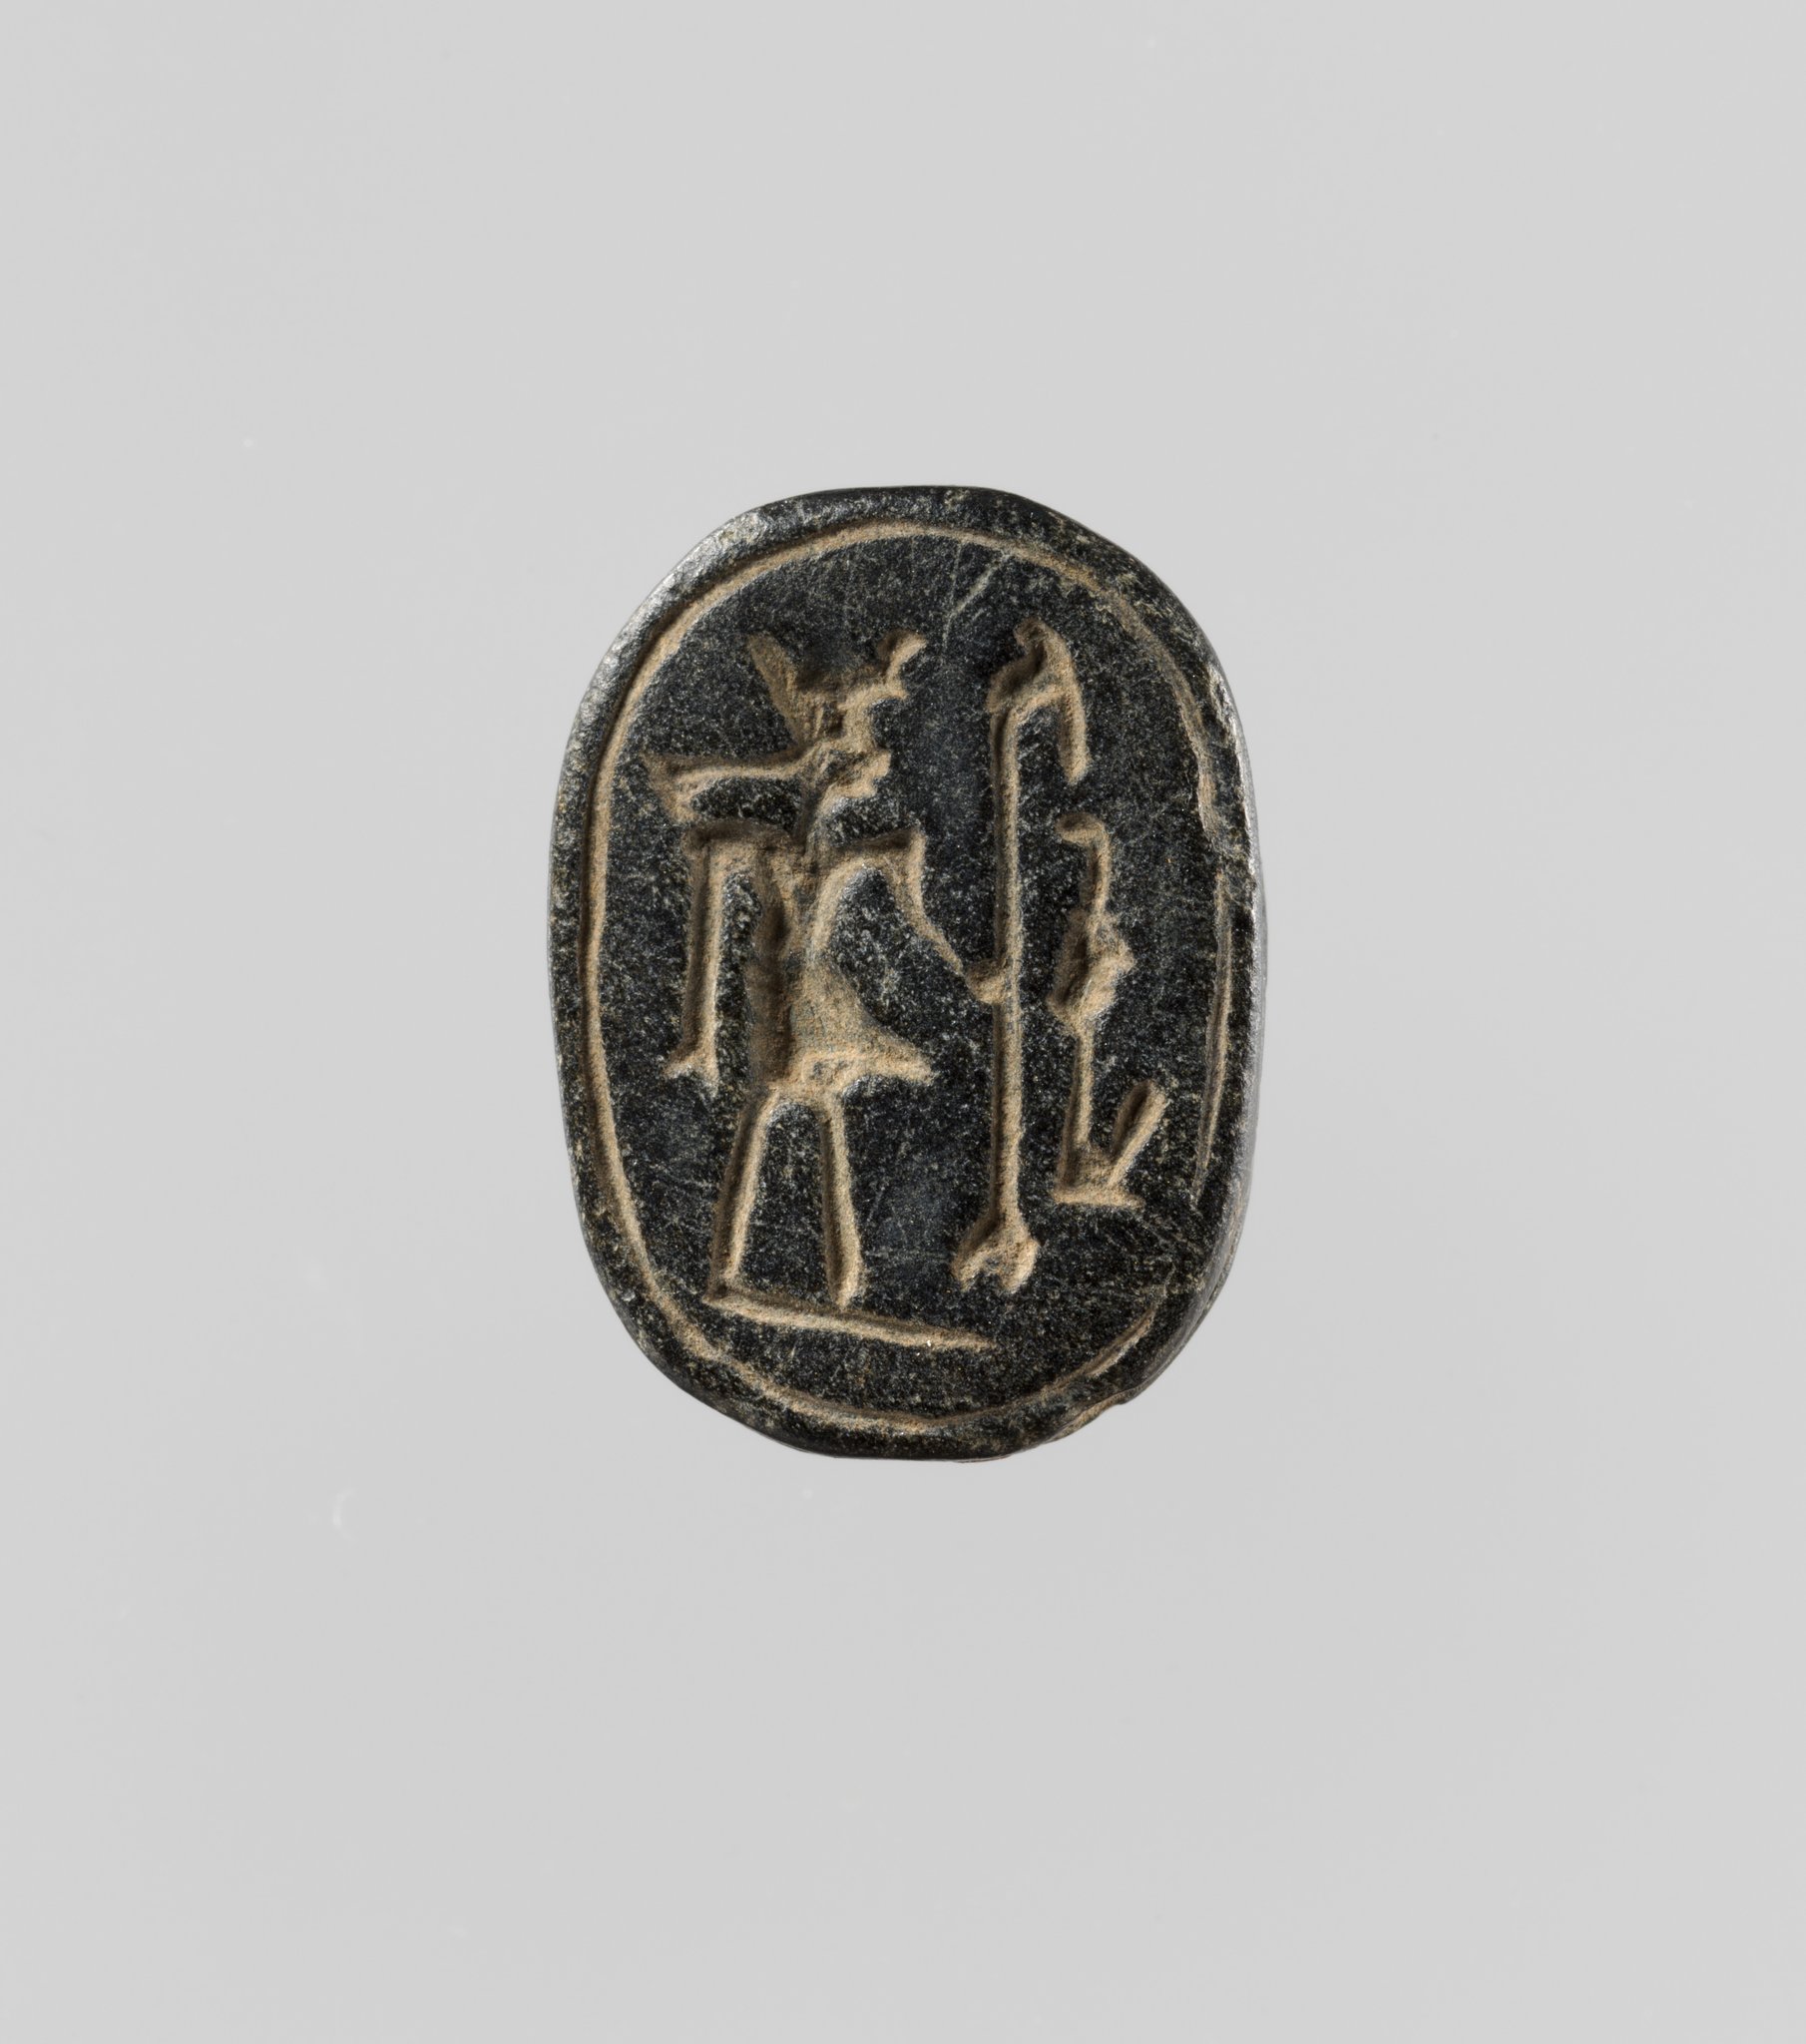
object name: scarab, baal, wa scepter, maat figure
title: Scarab with Representation of Baal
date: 1295-1070 BCE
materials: stone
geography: egypt